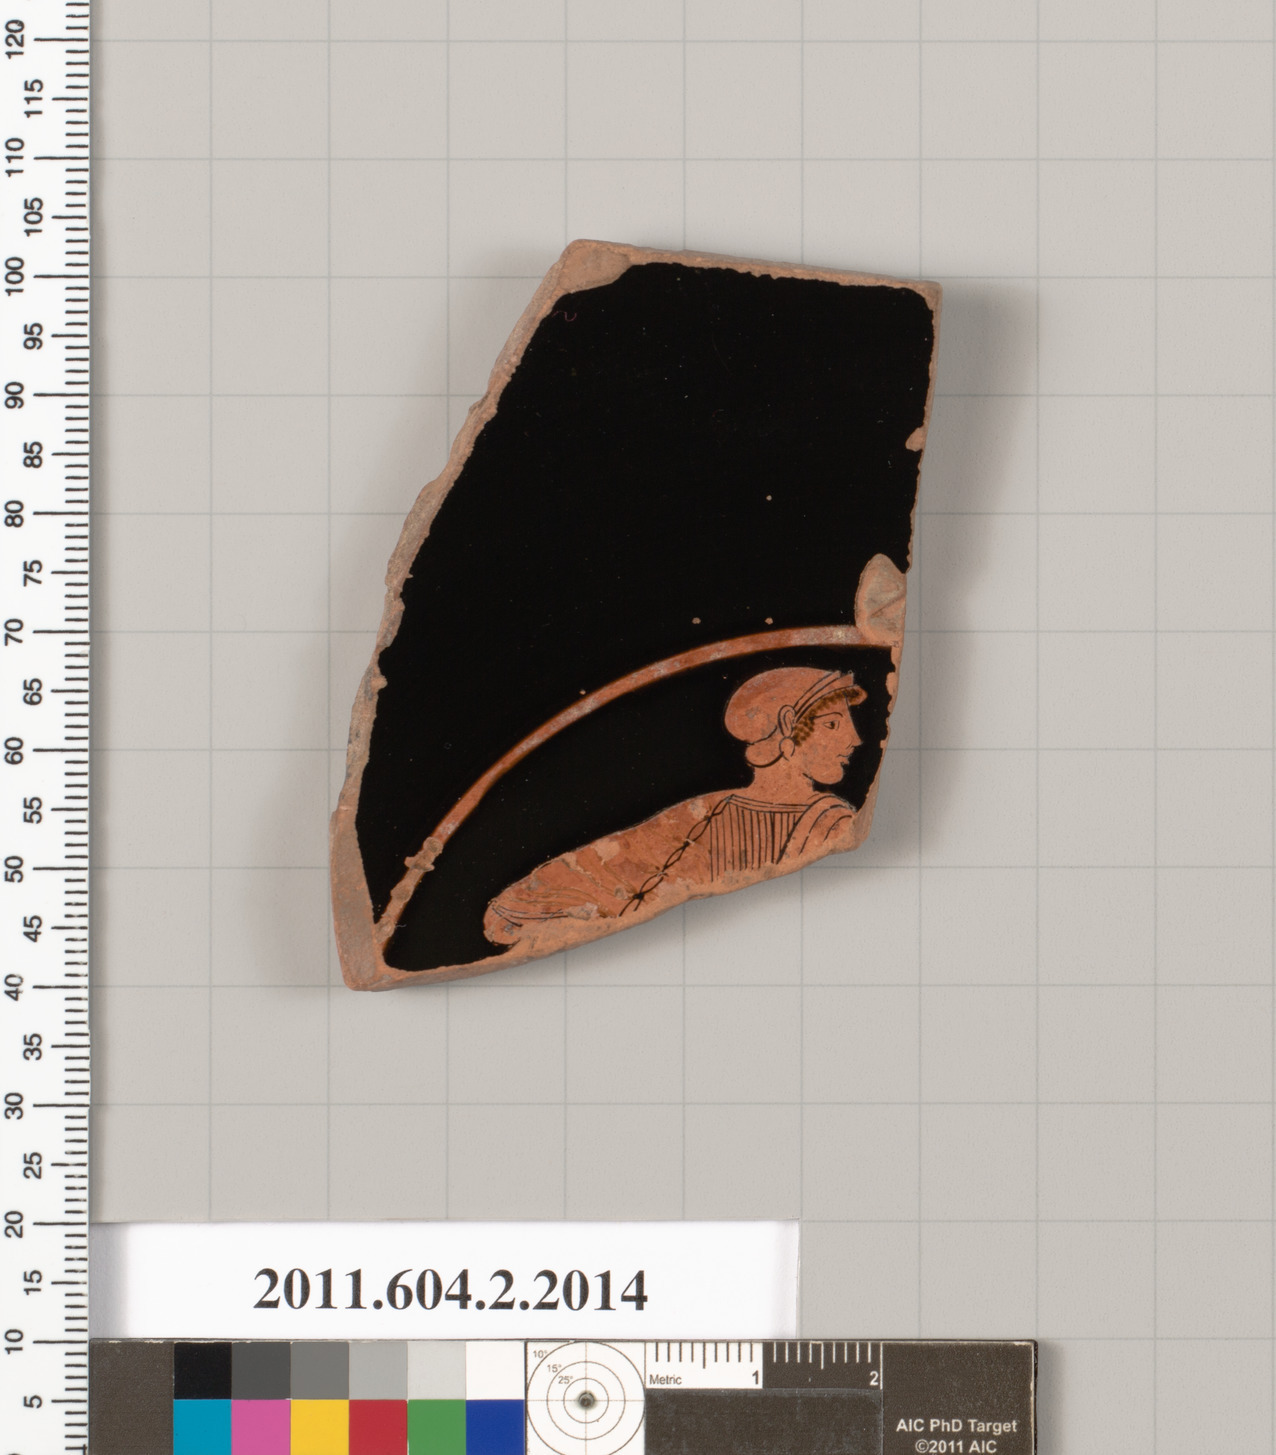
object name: plate fragment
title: Terracotta fragment of a stemmed plate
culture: greek, attic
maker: briseis painter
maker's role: artist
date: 480-470 BCE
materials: terracotta